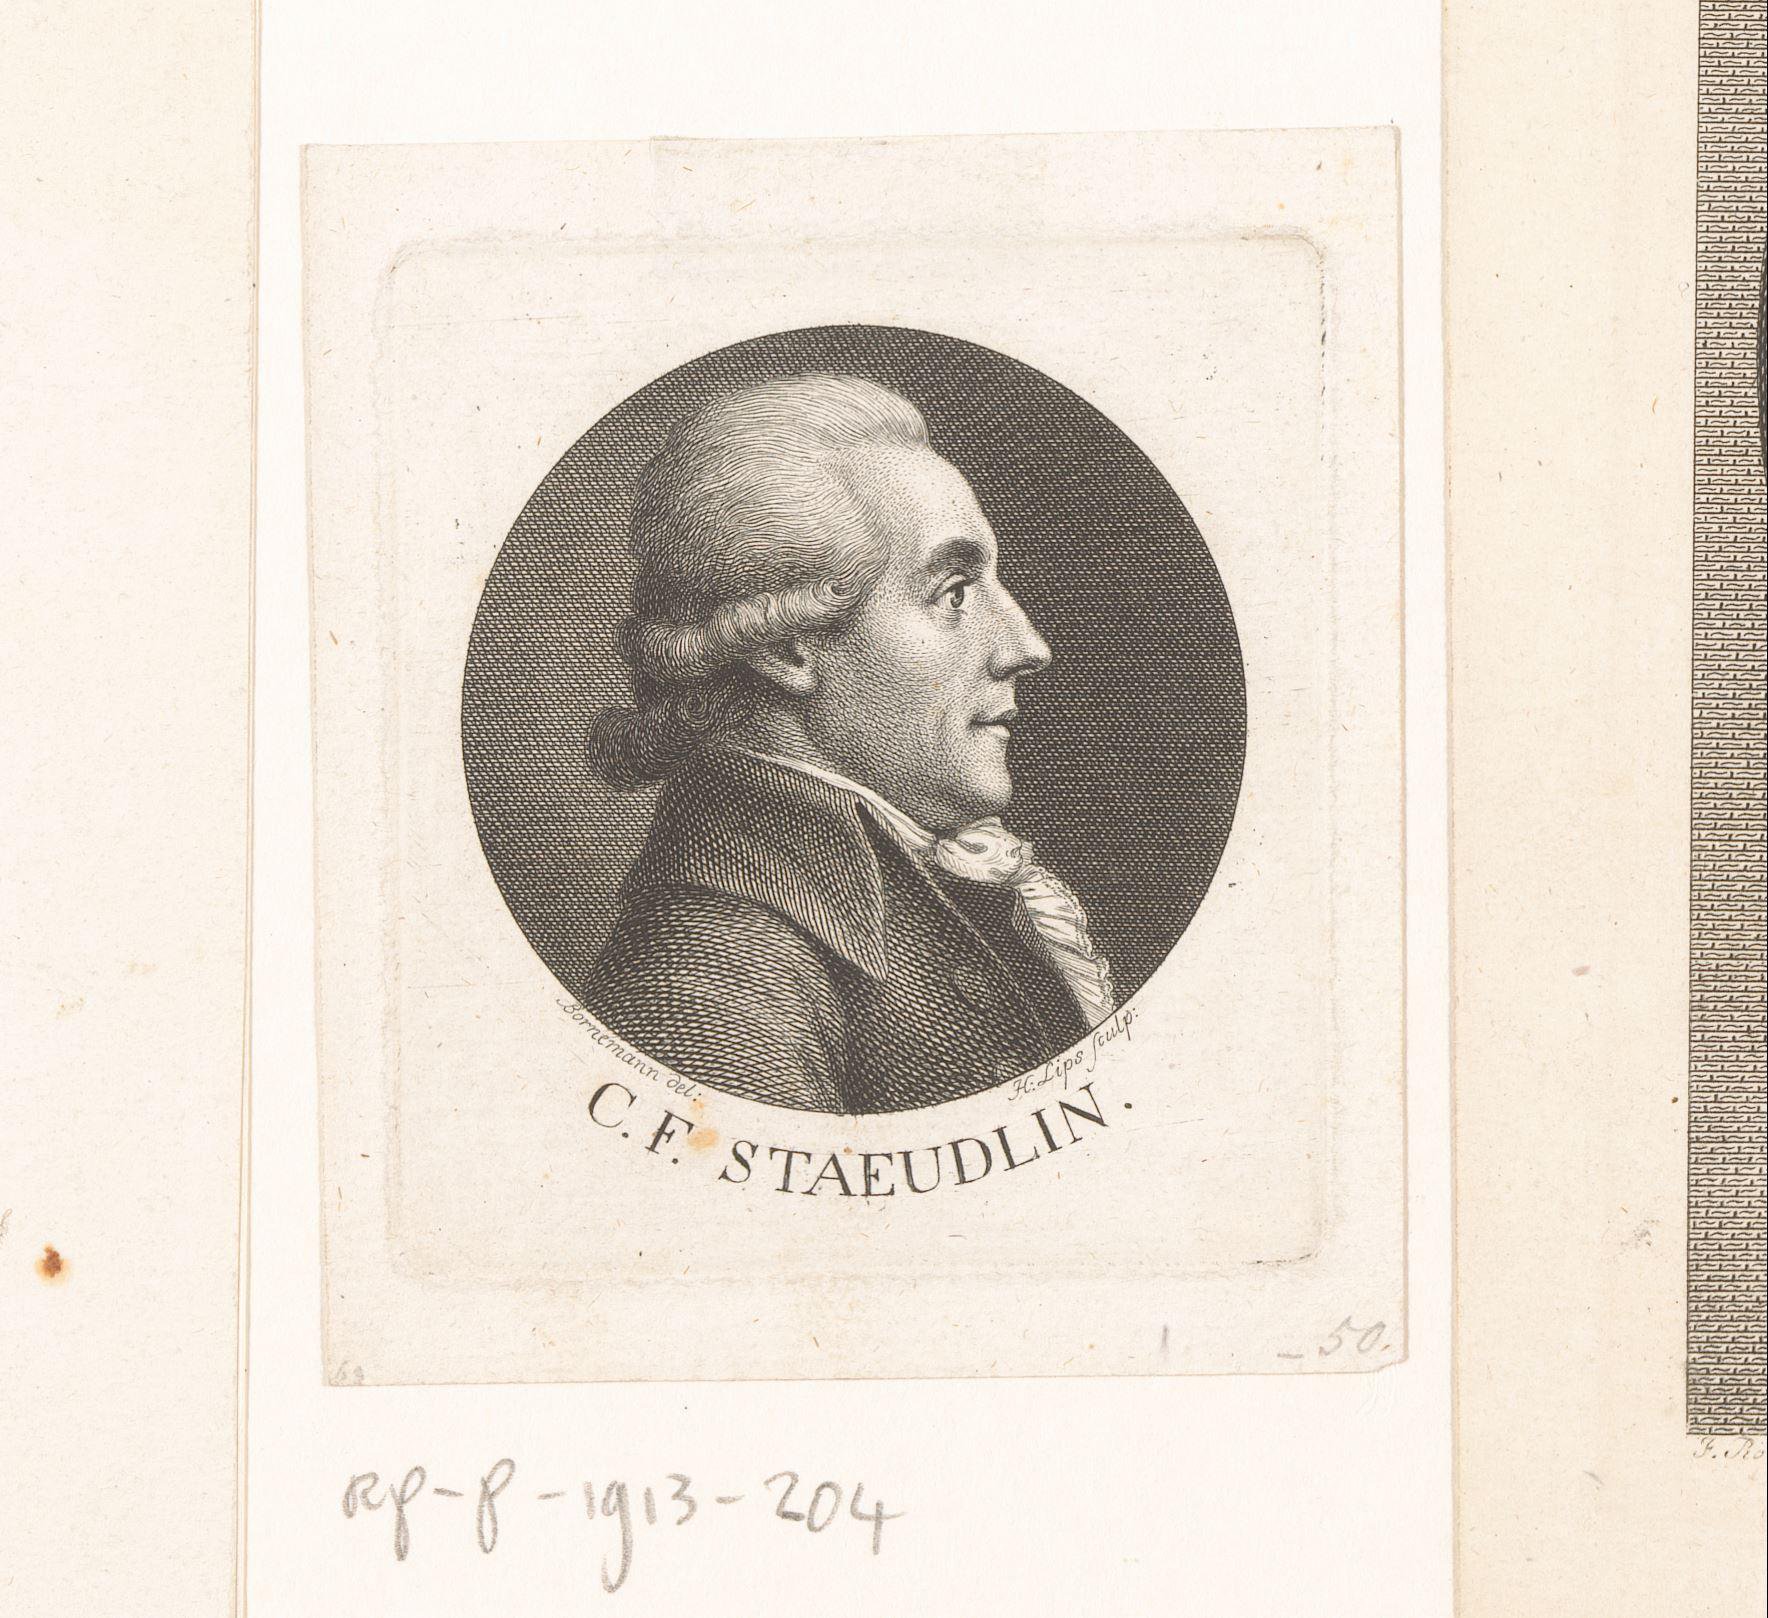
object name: print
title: Portret van Carl Friedrich Stäudlin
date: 1768-1817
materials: paper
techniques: engraving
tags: theologian, historical persons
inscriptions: collector's mark: Lugt 2228